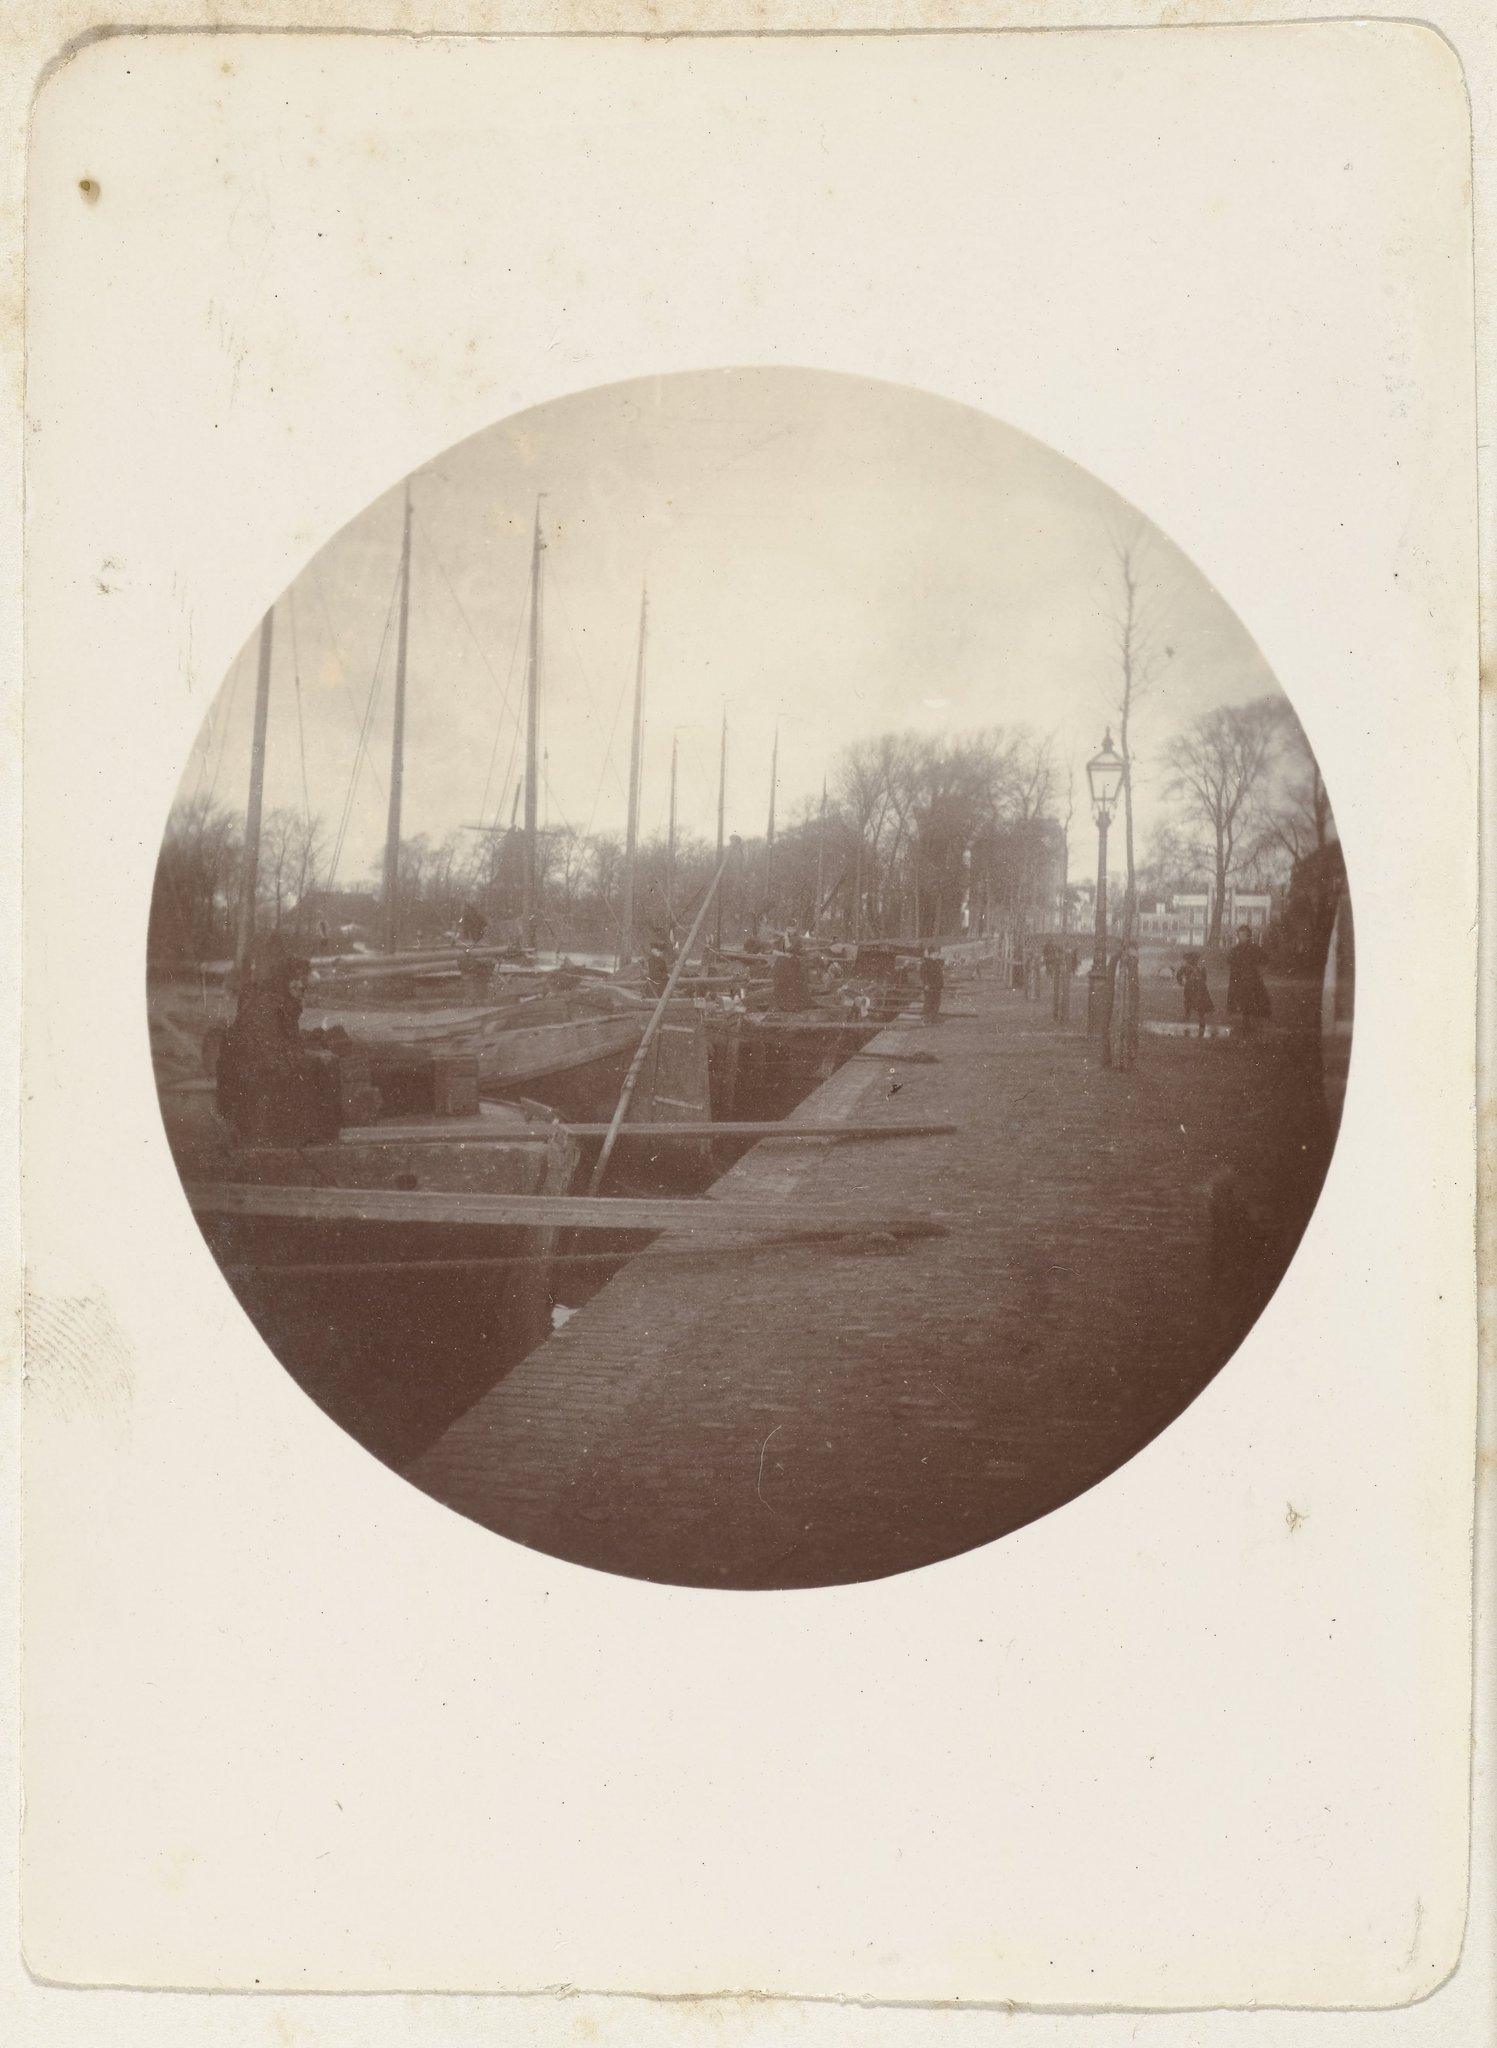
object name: photograph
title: Leeuwarden 1897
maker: Anonymous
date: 1897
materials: paper, cardboard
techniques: gelatin silver print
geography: leeuwarden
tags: harbour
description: Westerkade met aangemeerde schepen in Leeuwarden, gezien in de richting van de Oldehove. De foto is onderdeel van een albumblad met daarop foto's van Leeuwarden.